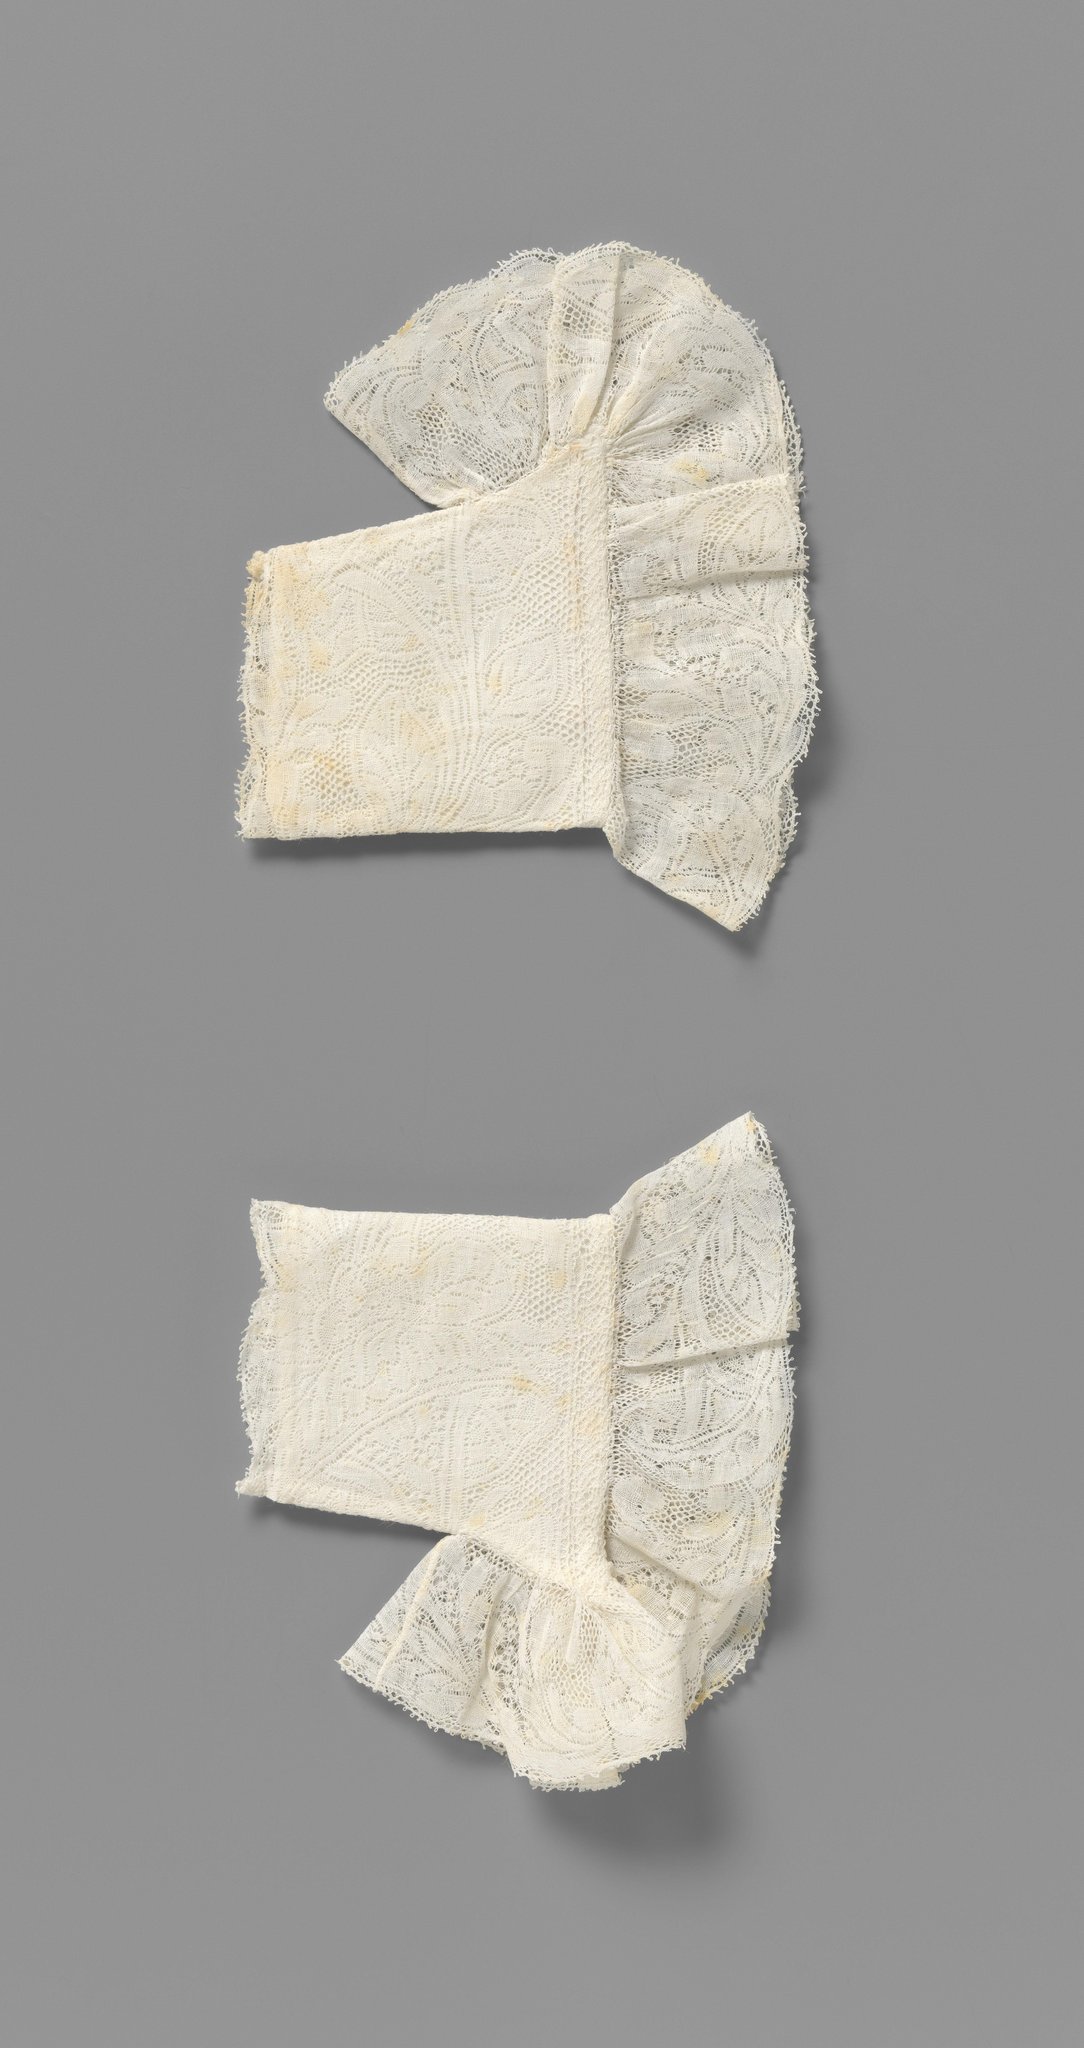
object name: mitt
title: Mitaine van wit linnen Binchekant met voering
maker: Anonymous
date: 1750-1800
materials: linen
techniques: lace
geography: netherlands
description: Linker mitaine van wit linnen Binchekant met aparte duim en ruche, voor baby.